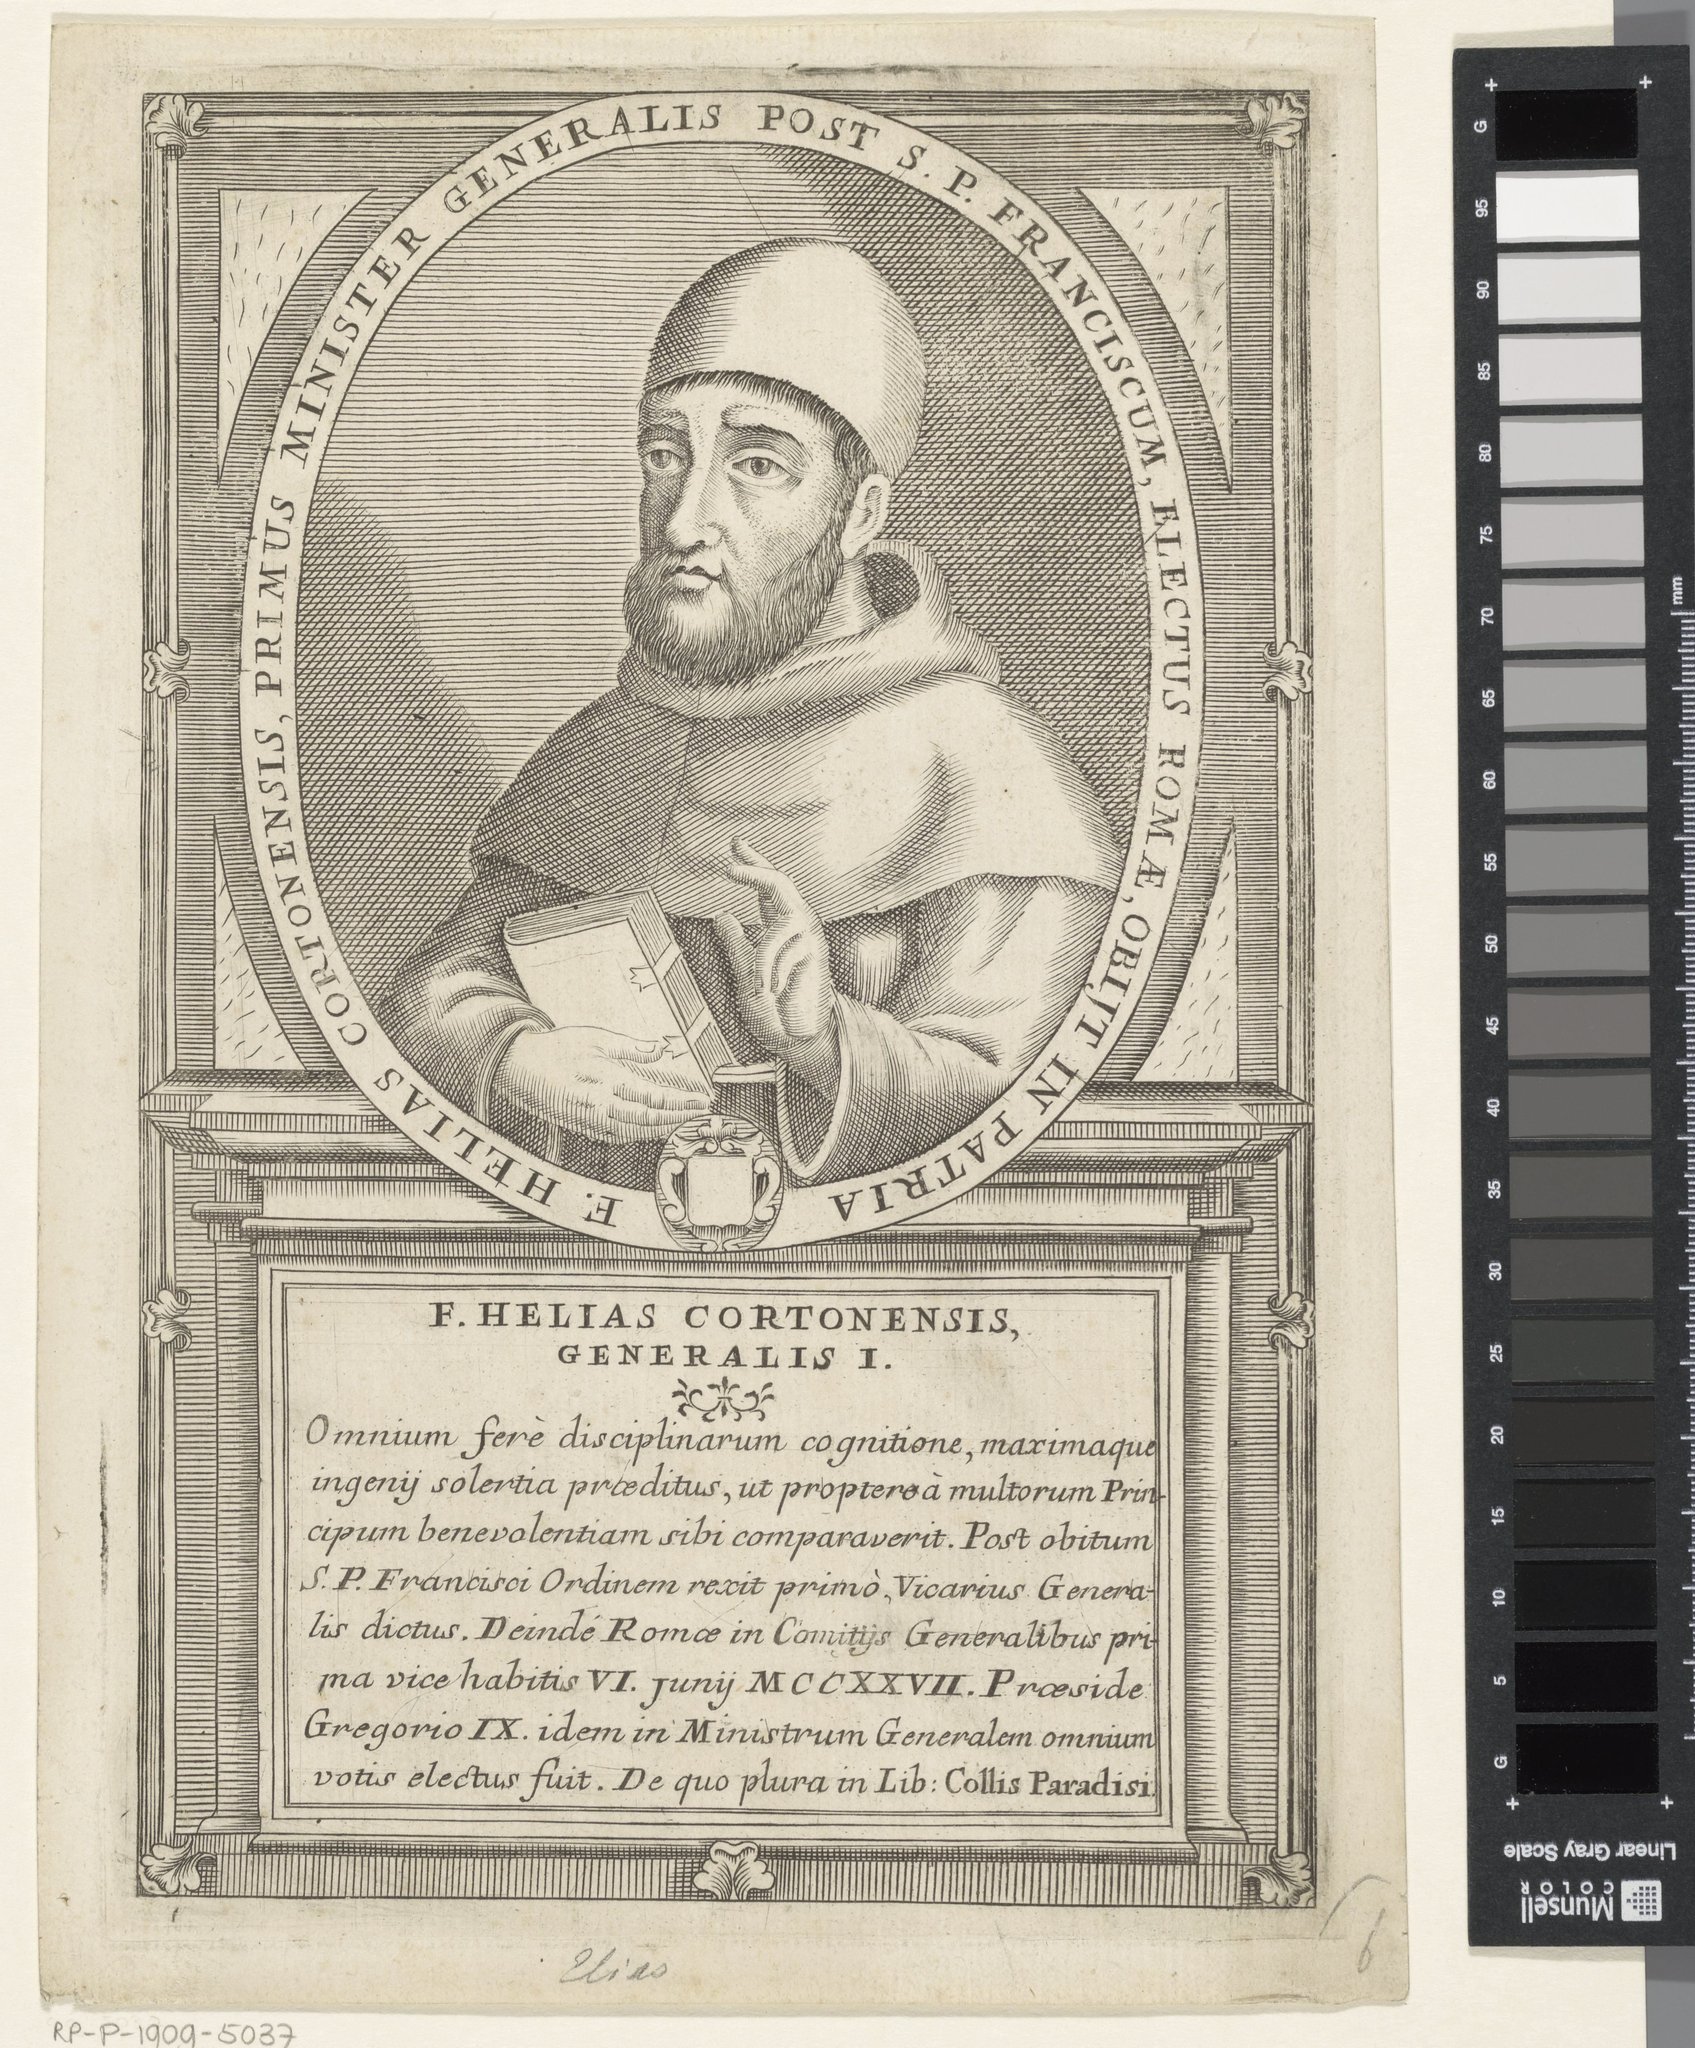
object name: print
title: Portret van Elia da Cortona, 2de Minister Generaal van de franciscaner orde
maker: antonio luciani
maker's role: print maker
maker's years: 1700-1738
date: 1710-1738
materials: paper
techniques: engraving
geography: italy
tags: clergyman, historical persons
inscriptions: collector's mark: Lugt 2228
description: Deze prent maakt deel uit van een groep van 60 portretten.